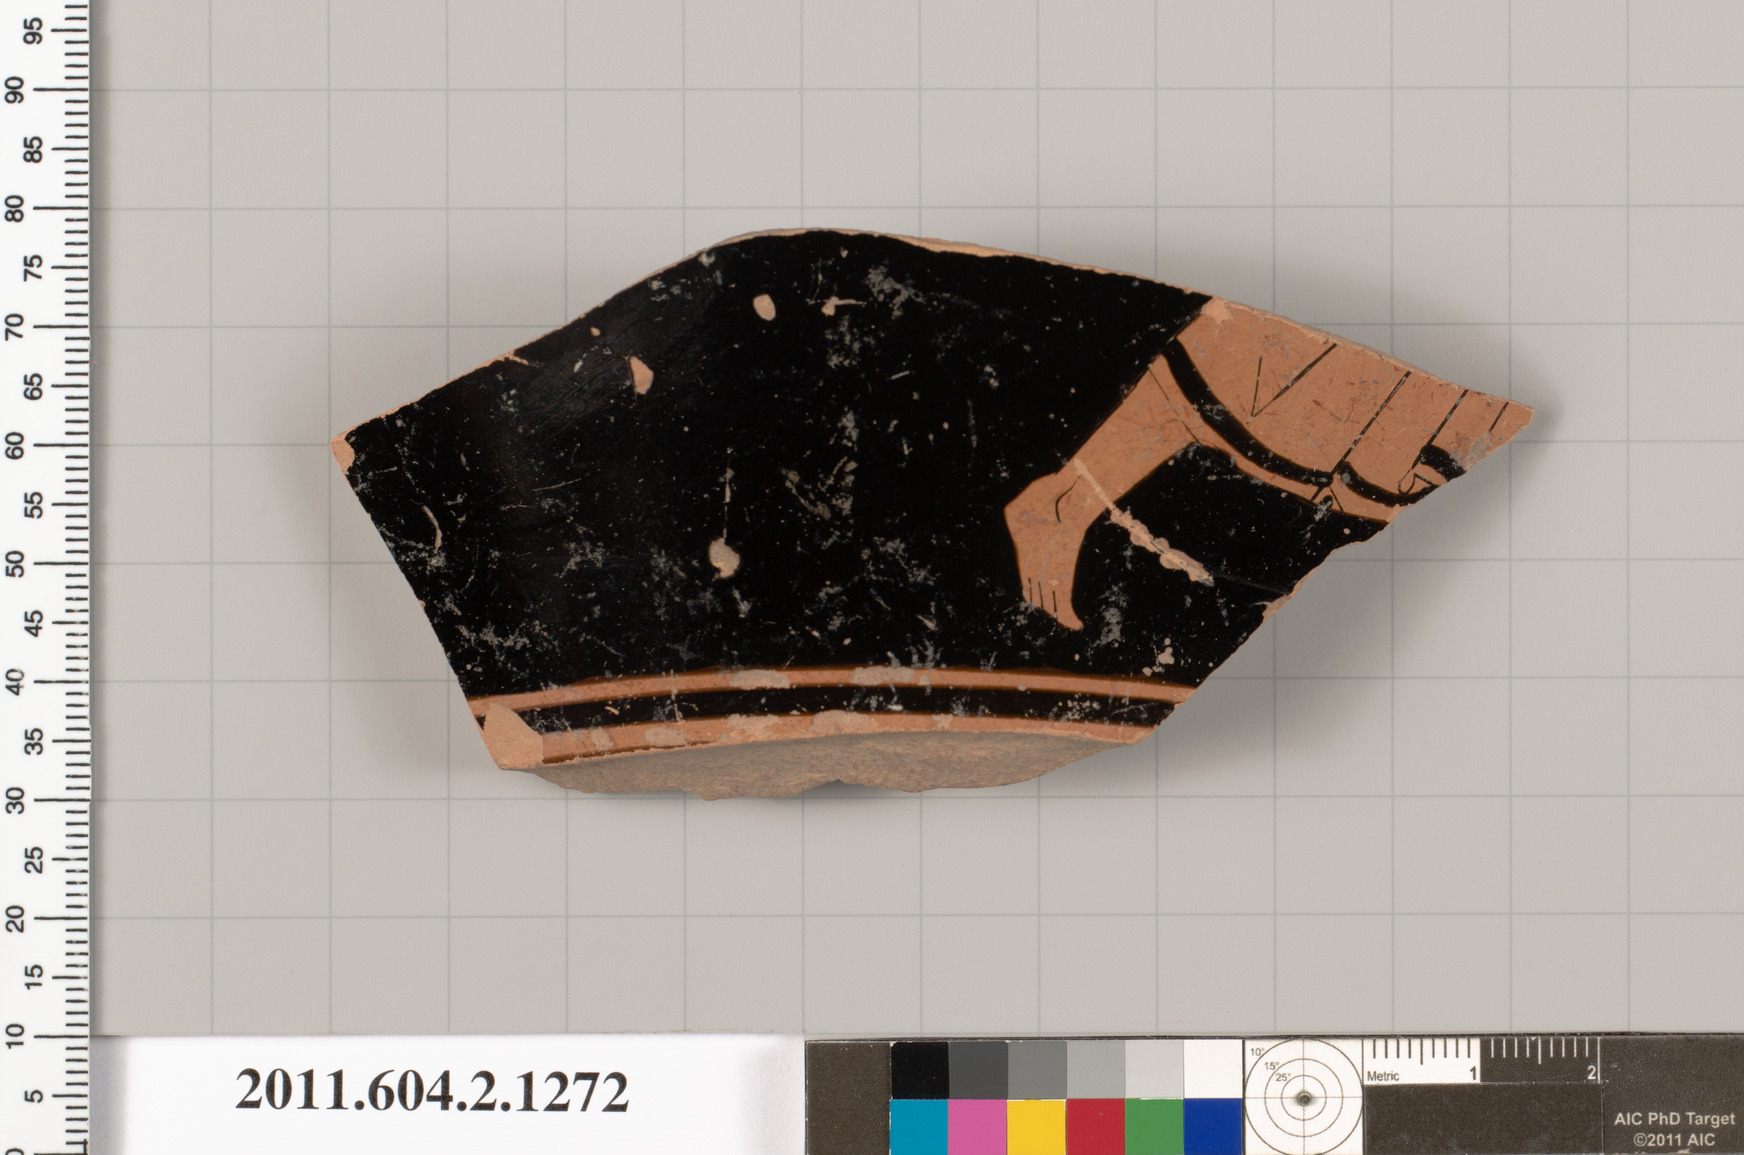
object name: skyphos fragment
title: Terracotta fragment of a skyphos (deep drinking cup)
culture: greek, attic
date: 475-451 BCE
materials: terracotta